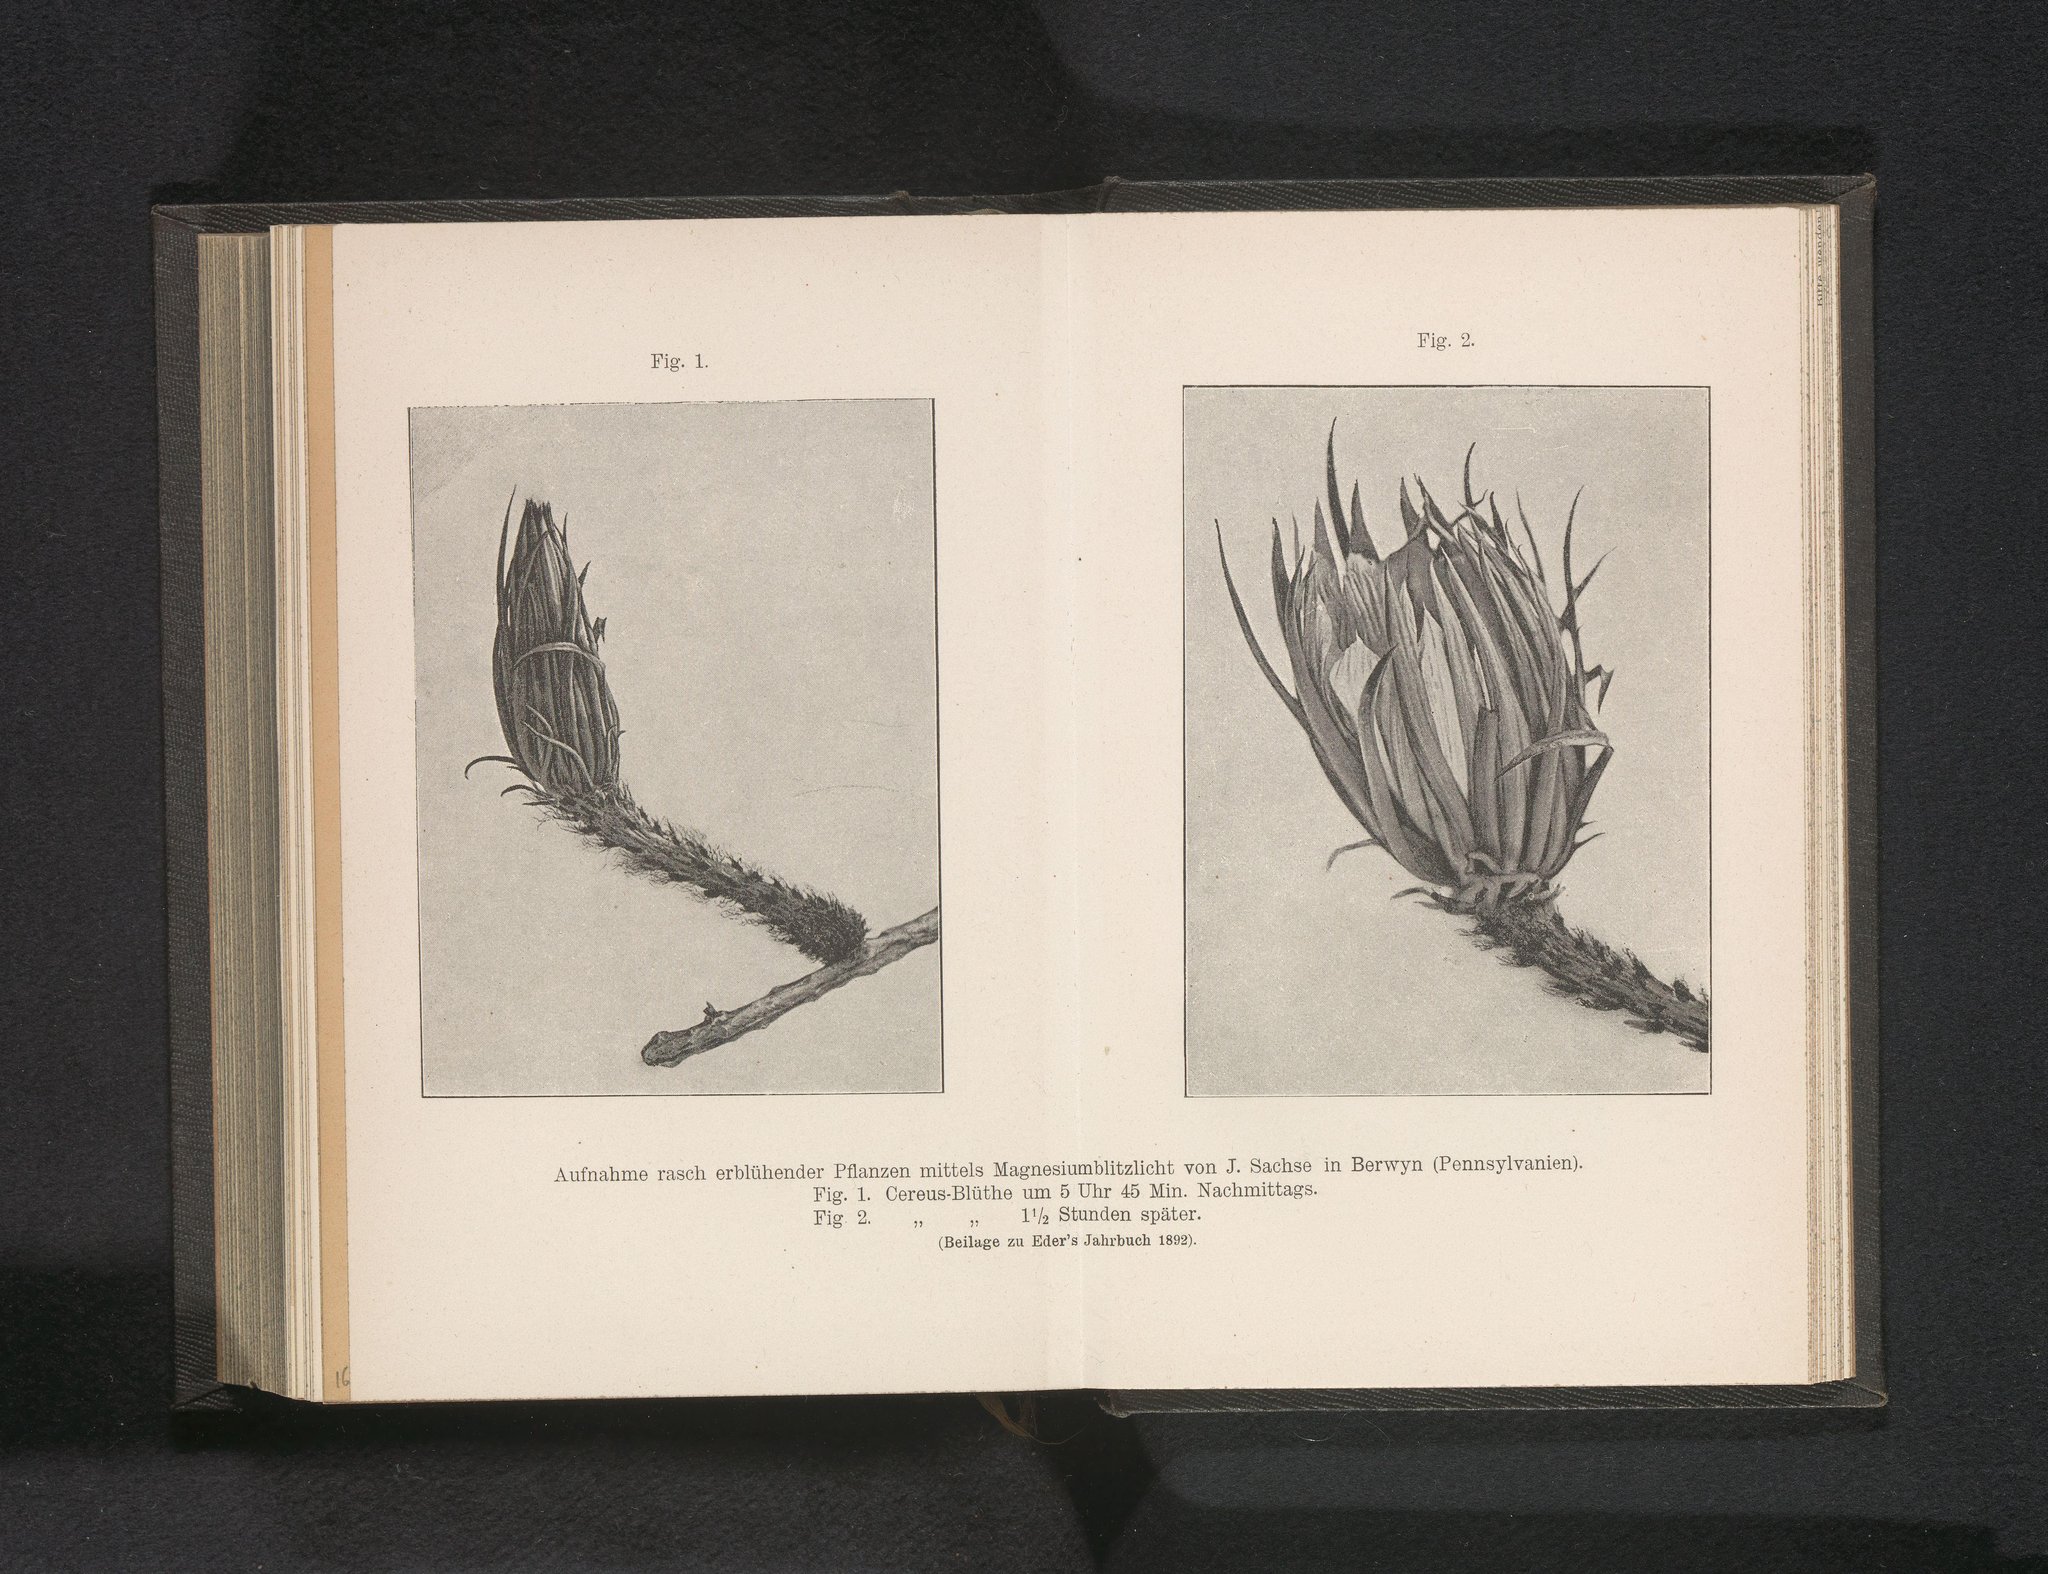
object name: page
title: Bloem van een cereus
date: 1887-1892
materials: paper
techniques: autotype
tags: plants and herbs: cactus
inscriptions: inscription: ‘Aufnahme rasch erblühender Planzen mittel Magnesiumblitzlicht von J. Sachse in Berwyn (Pennsylvanien)./ Fig. 1. Cereu-Blüthe um 5 Uhr 45 Min. Nachmittags/ Fig. 2. Cereus-Blüthe 1 1/2 Sunden später.’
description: Prent op vijfendertigste ongenummerde pagina na pagina 520.